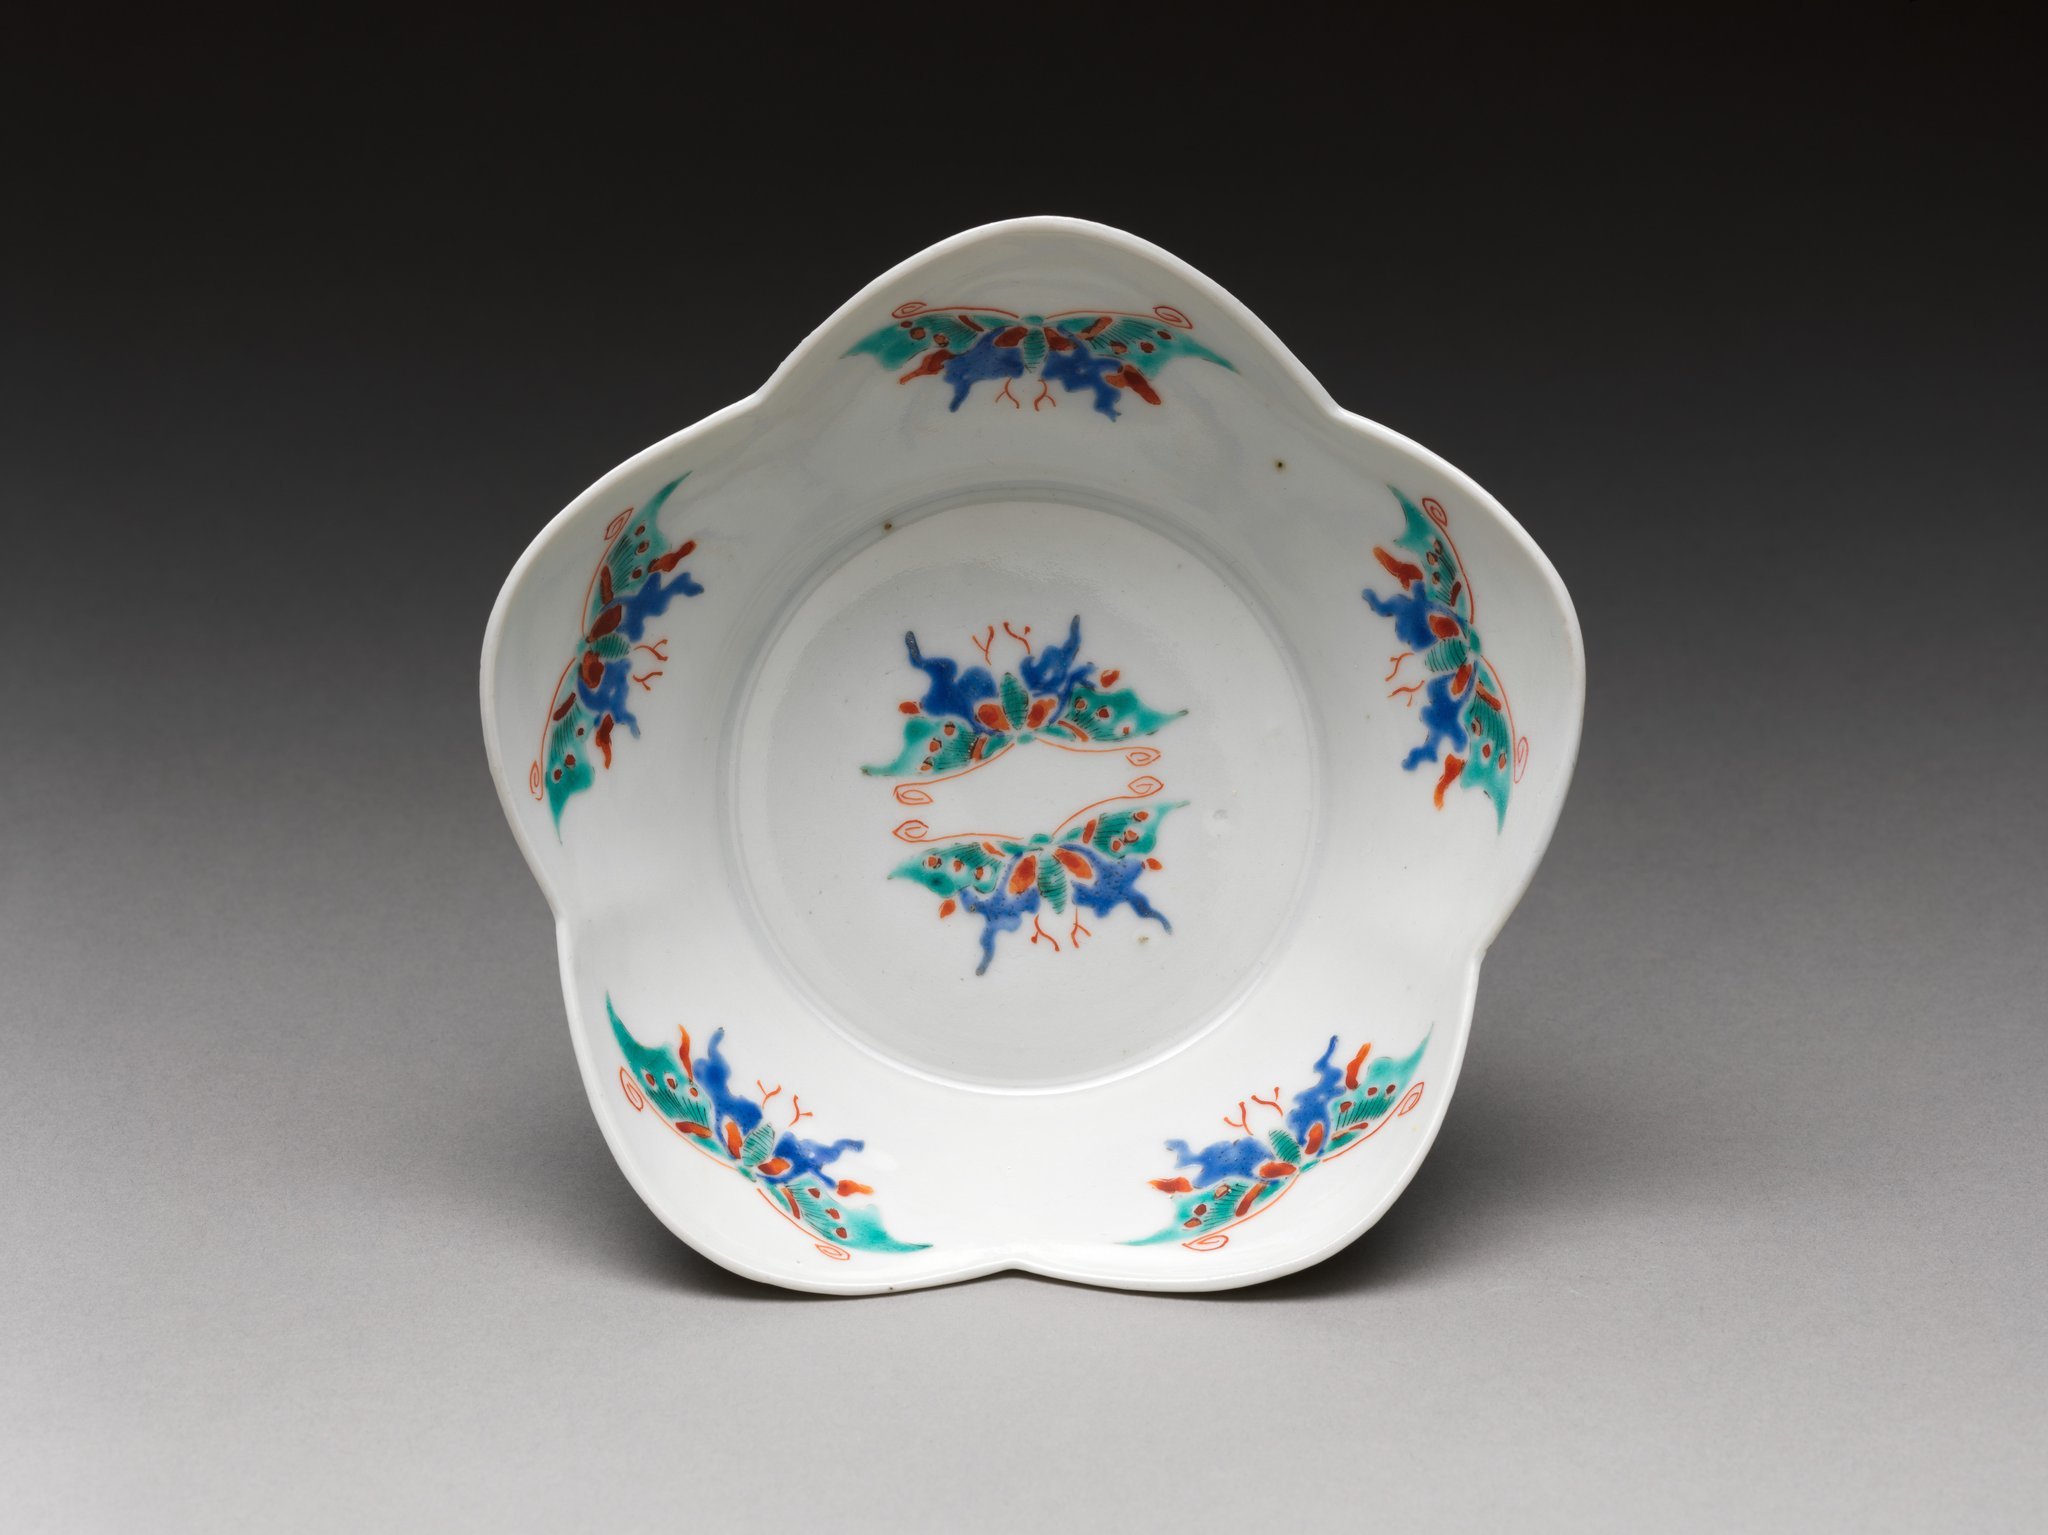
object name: saucer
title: Saucer with butterflies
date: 1700-1710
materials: enamel, glaze, hard paste porcelain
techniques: painting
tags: butterflies